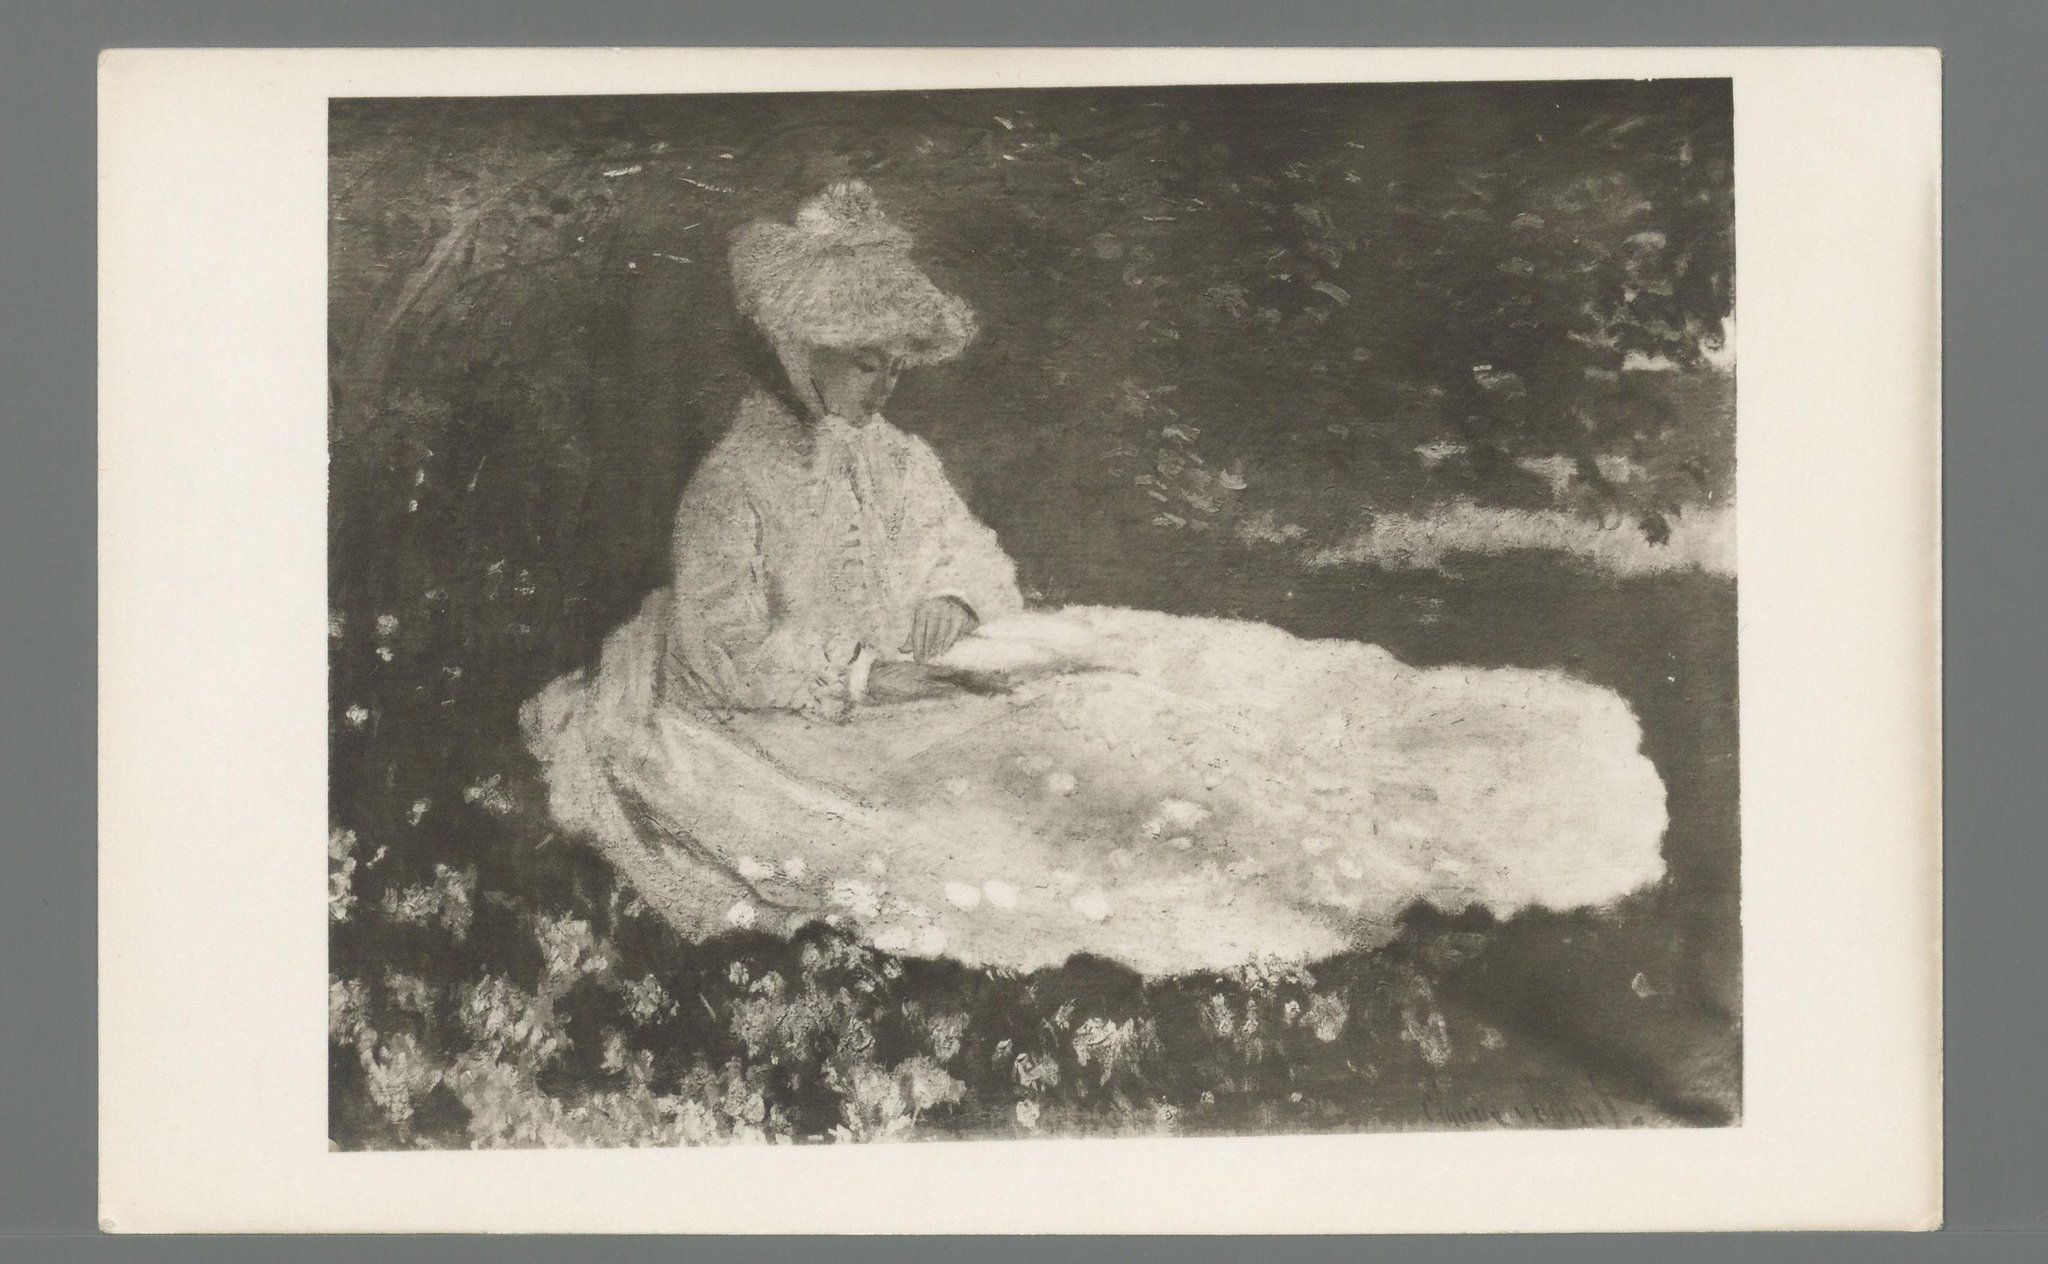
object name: ansichtkaart, prentbriefkaart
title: Springtime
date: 1931-1960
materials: photographic support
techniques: photography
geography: baltimore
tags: meadow, pasture, adult woman (+ sitting), dress, gown